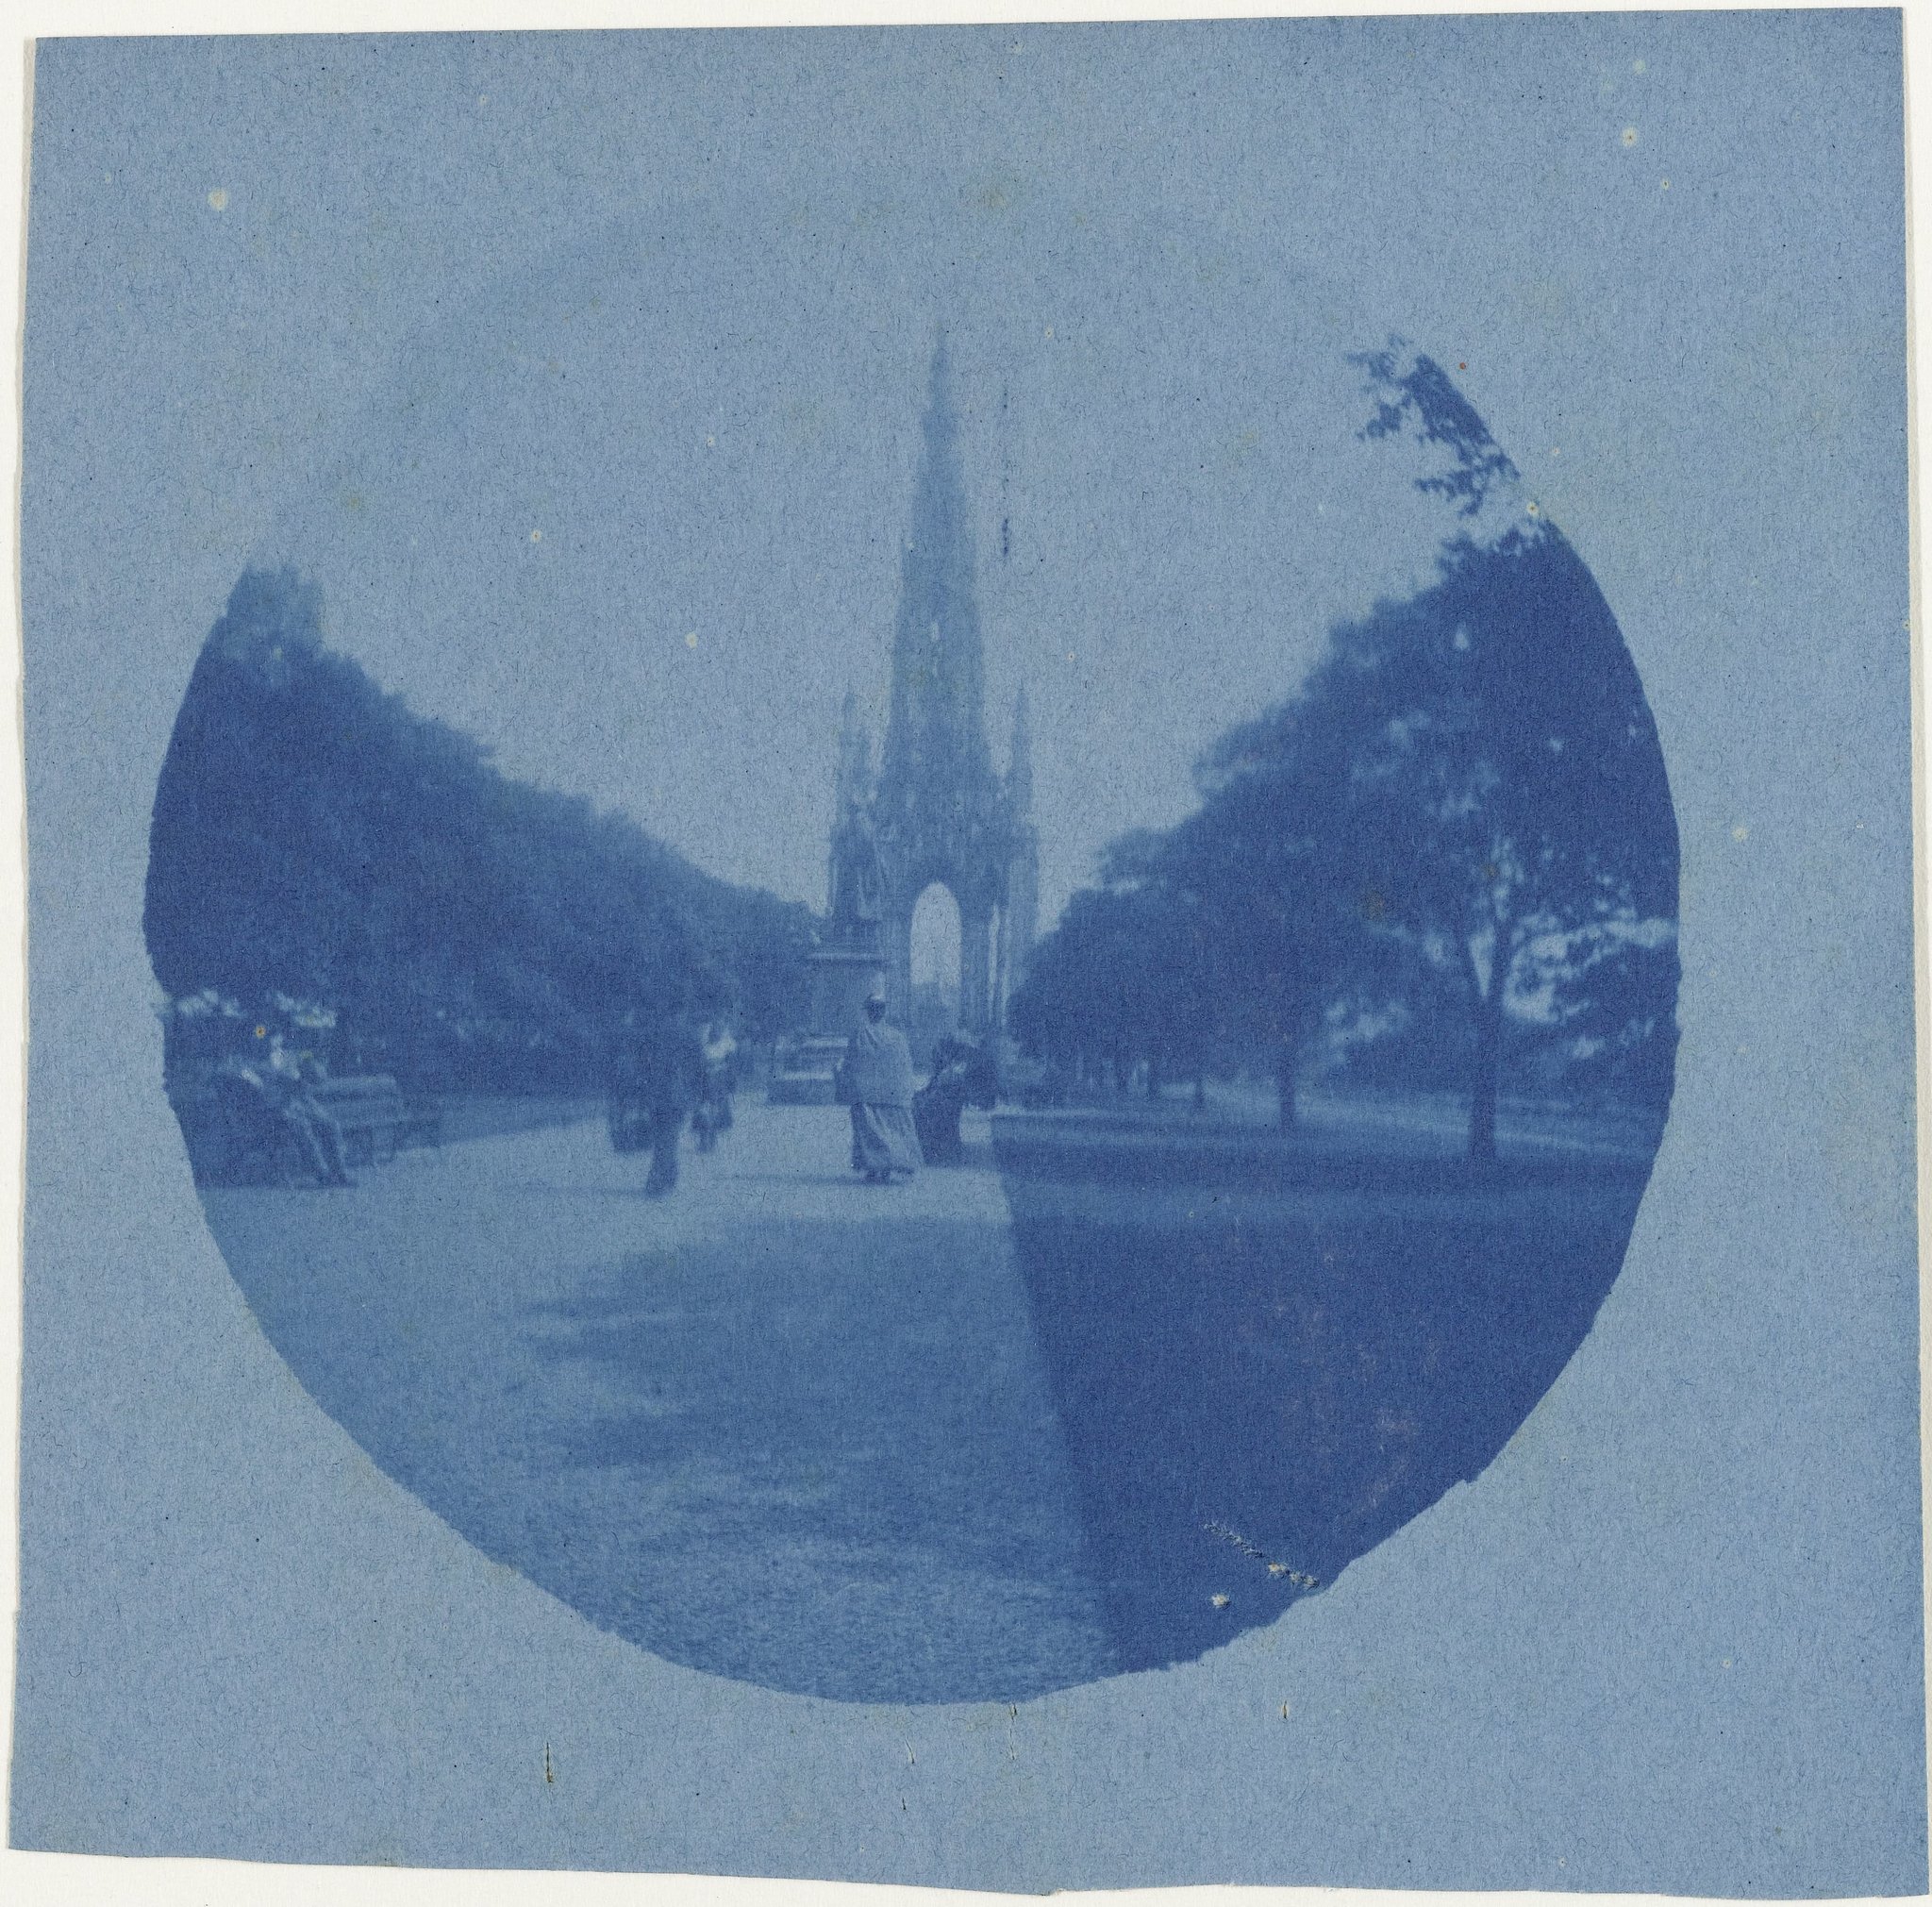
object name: photograph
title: Sir Walter Scott Monument te Edinburgh, Schotland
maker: Anonymous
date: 1890-1910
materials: paper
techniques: cyanotype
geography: edinburgh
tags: monument, statue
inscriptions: annotation: ‘Walter Scott/ Monument/ Edinburgh’